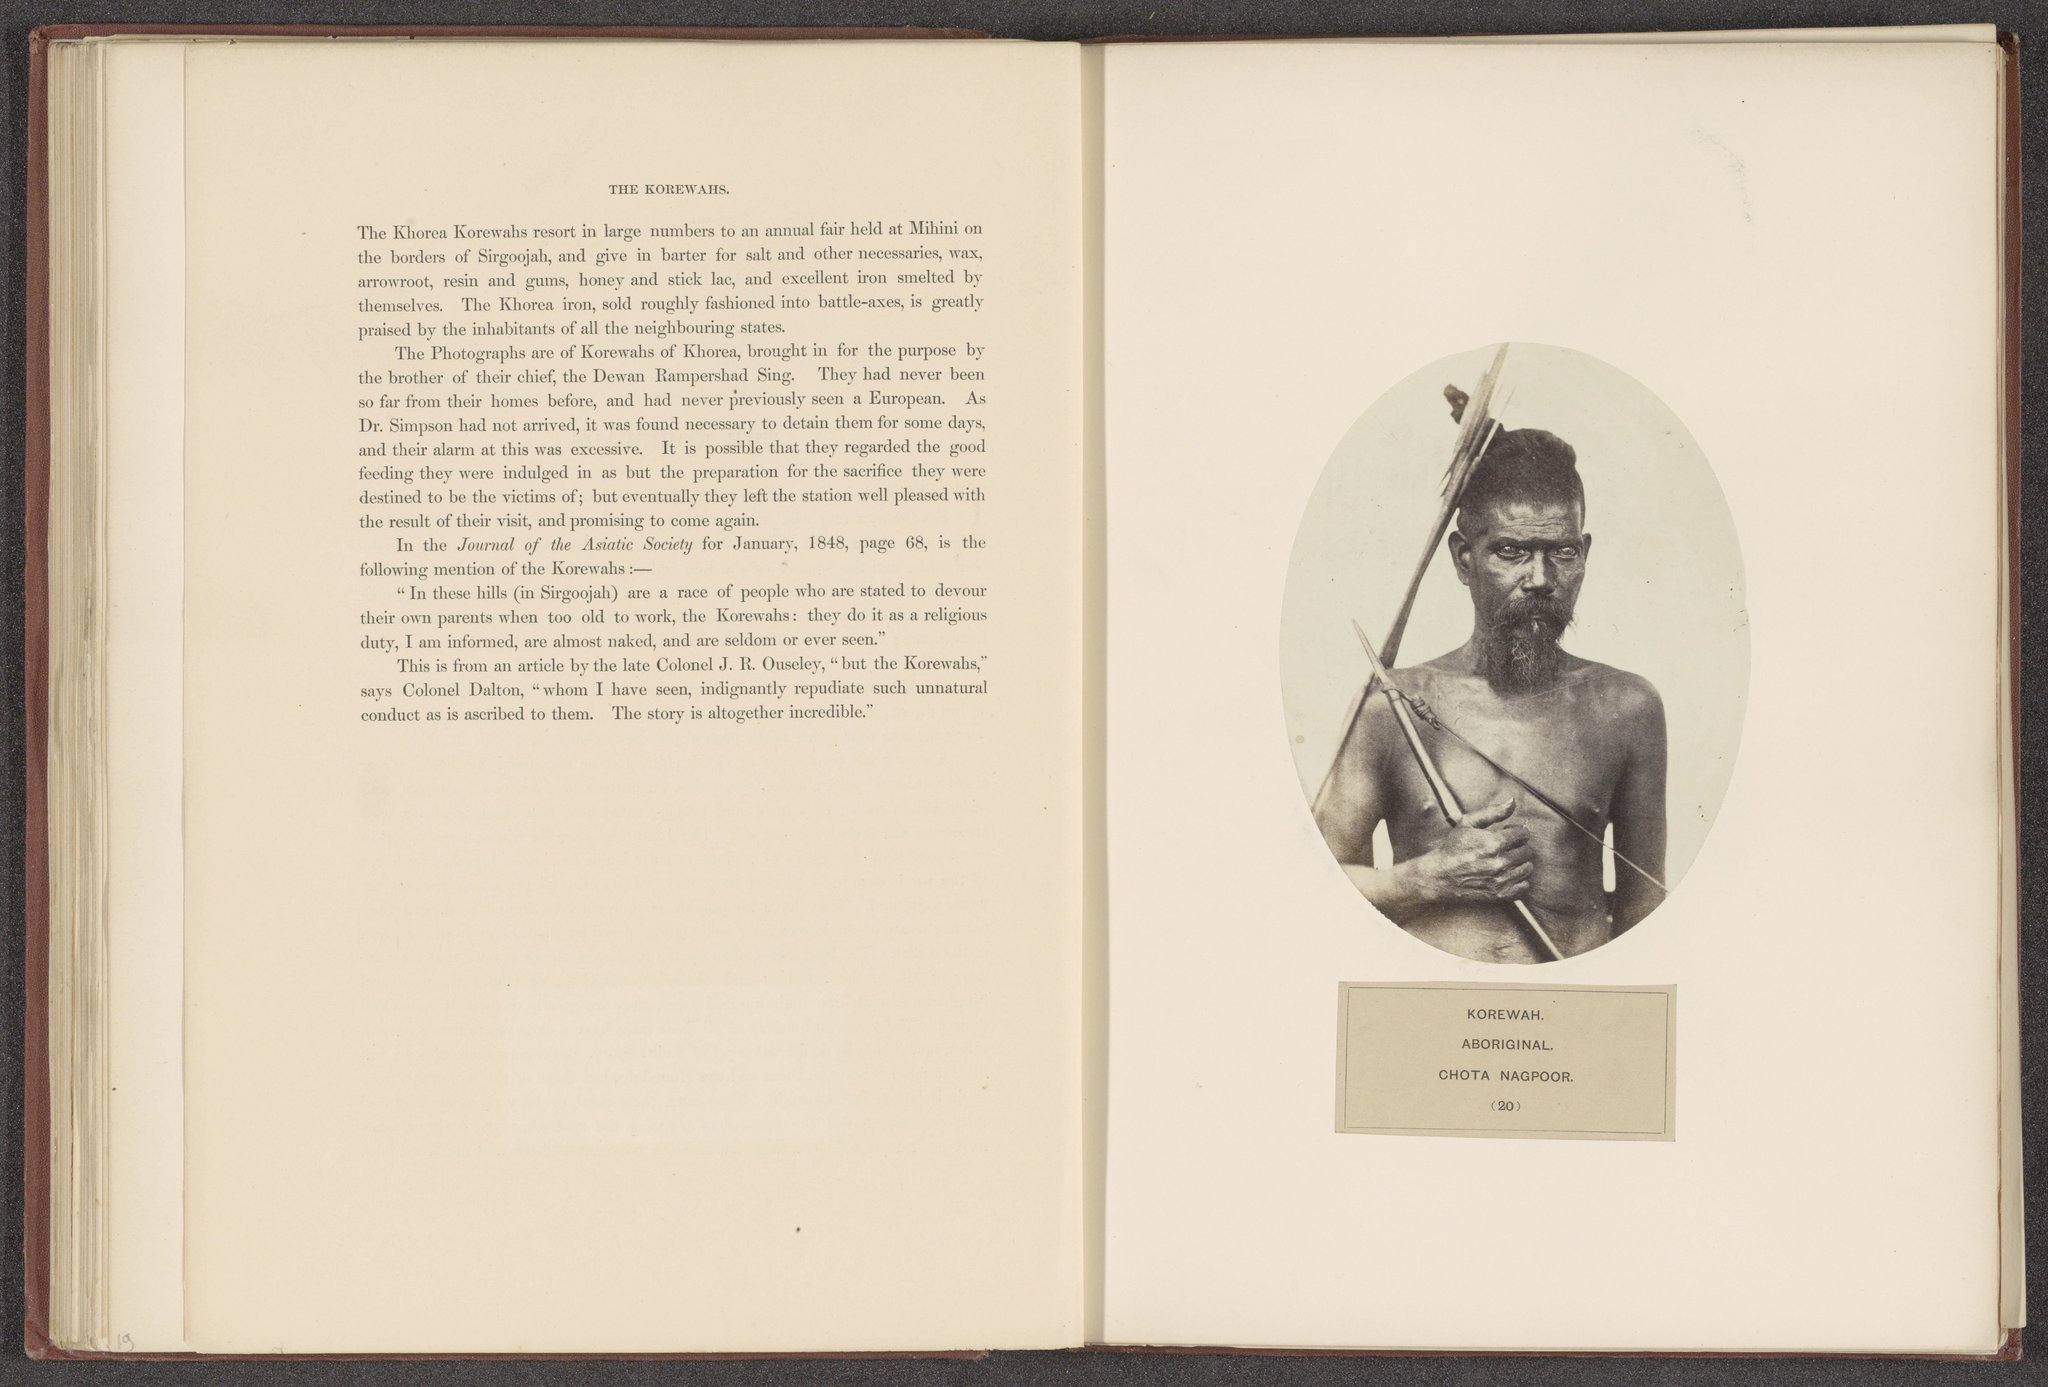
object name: page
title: Portait of an unknown man with a bow and arrow from the Korwa tribe of Chota Nagpur in eastern India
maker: benjamin simpson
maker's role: fotograaf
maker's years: 1831-1923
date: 1858-1868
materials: photographic support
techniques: albumen print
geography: chota nagpur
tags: archer's weapons: bow and arrow, human races; peoples; nationalities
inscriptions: number: ‘(20)’, inscription: ‘KOREWAH./ ABORIGINAL./ CHOTA NAGPOOR.’